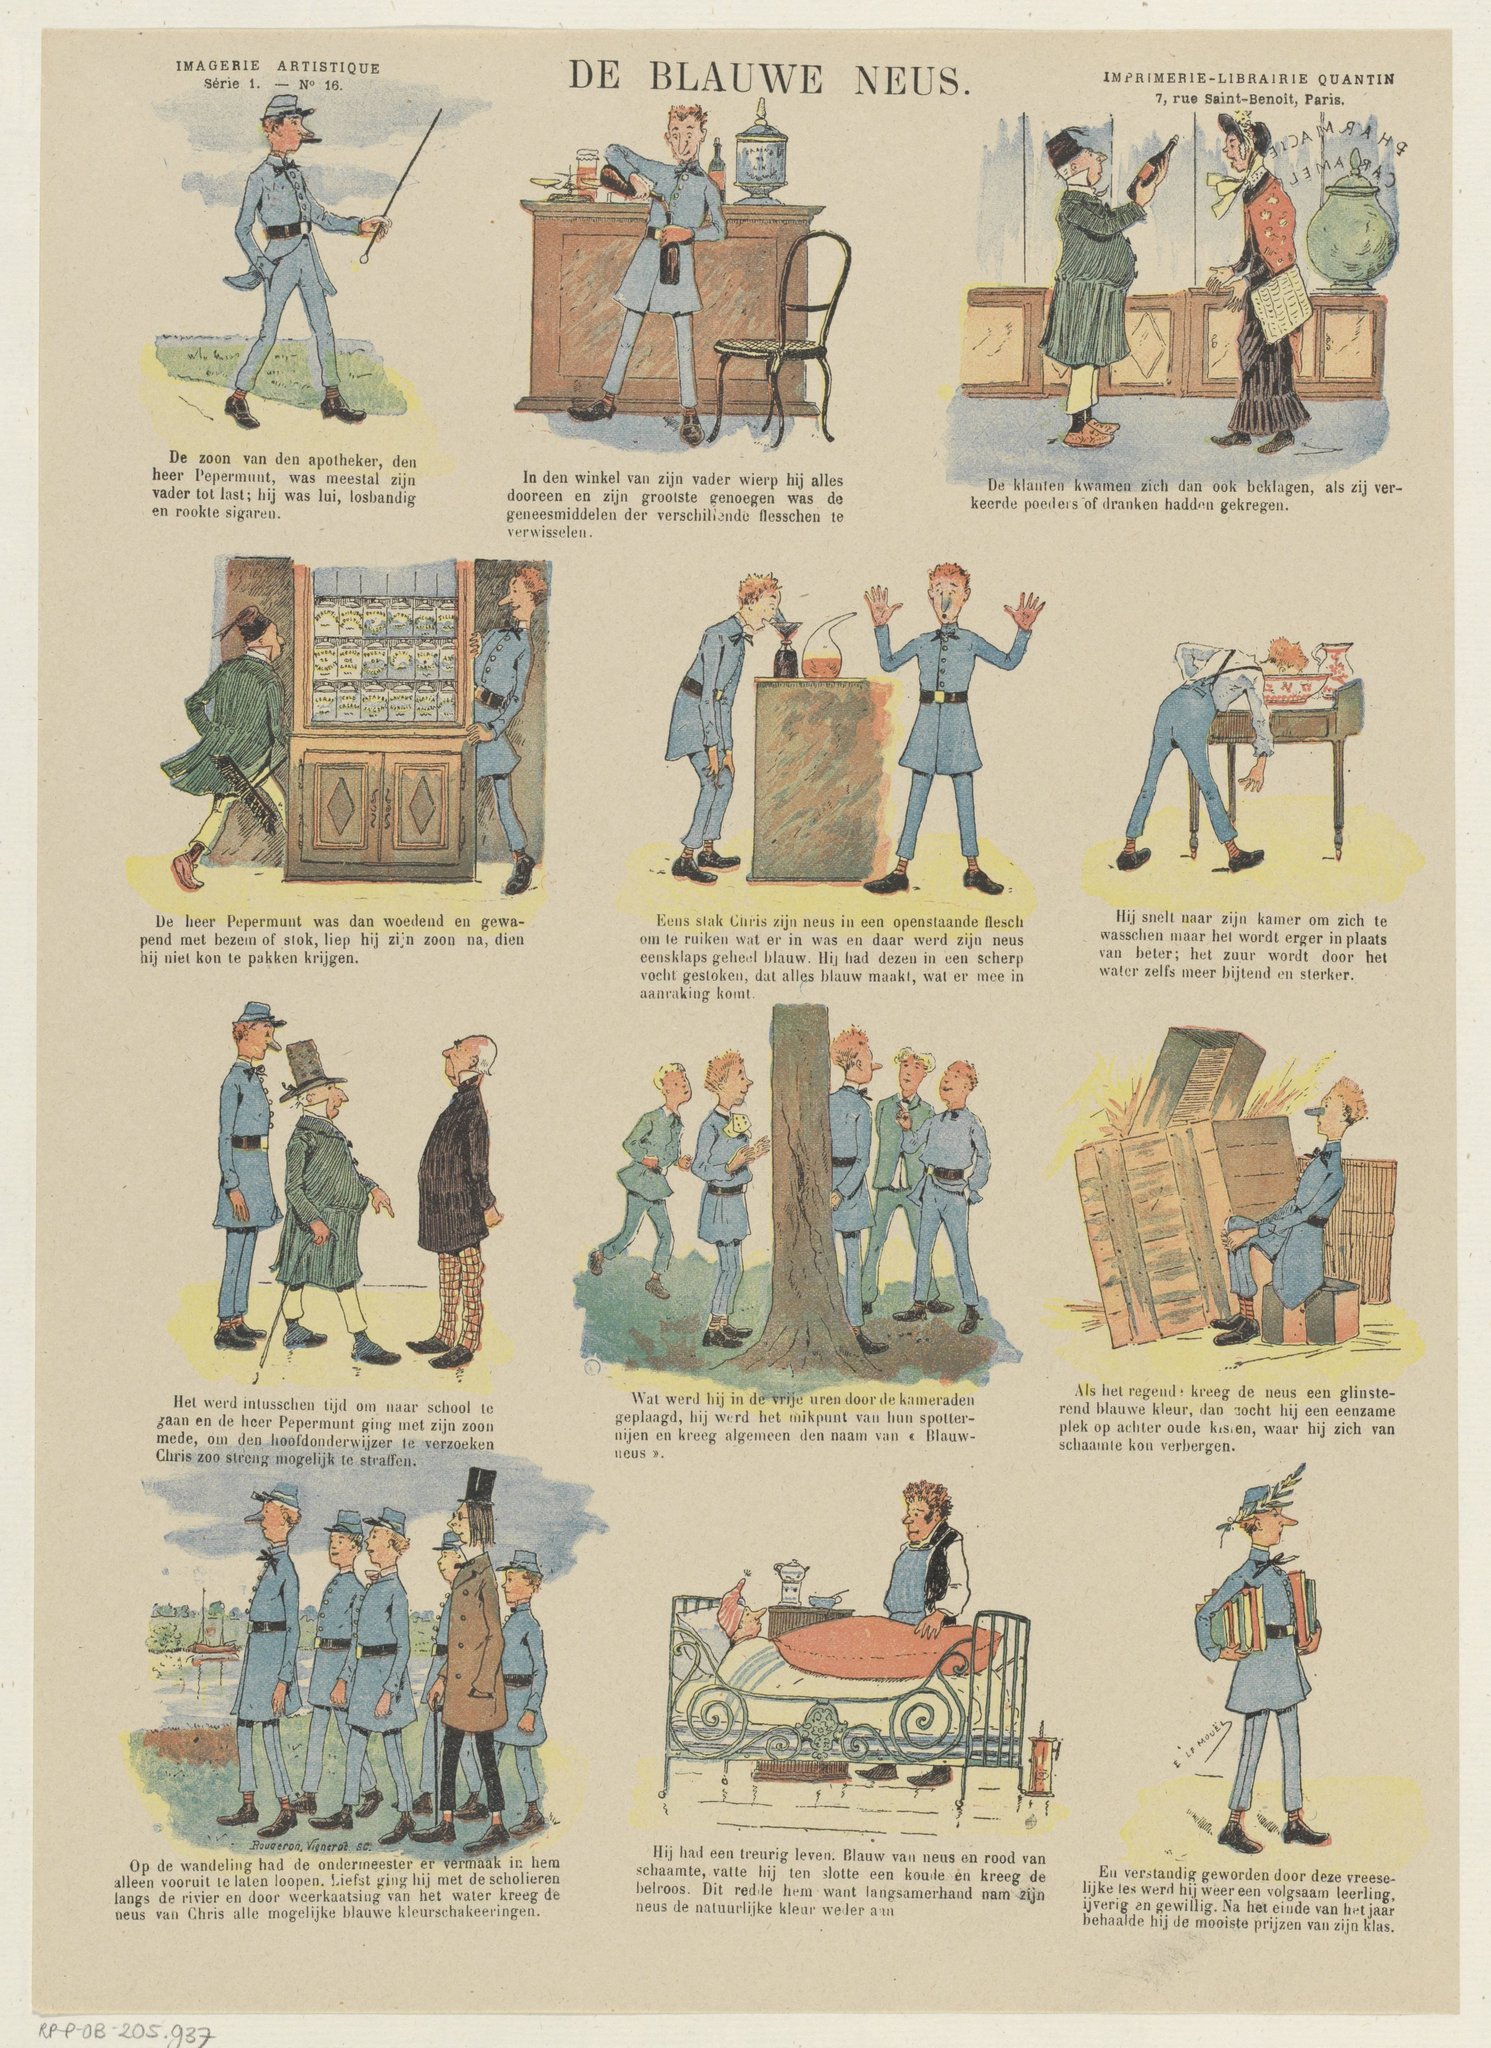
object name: print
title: Imagerie Artistique / Série 1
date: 1876-1890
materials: paper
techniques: lithograph, letterpress printing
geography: paris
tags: pharmacist, druggist, apothecary; pharmacy, drugstore, dispensing chemist, tales and fairy tales, comedy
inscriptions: collector's mark: Lugt 2760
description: Blad met 12 voorstellingen van de zoon van de apotheker die een blauwe neus krijgt. Onder elke voorstelling een onderschrift. Genummerd linksboven: Série 1. - No. 16.